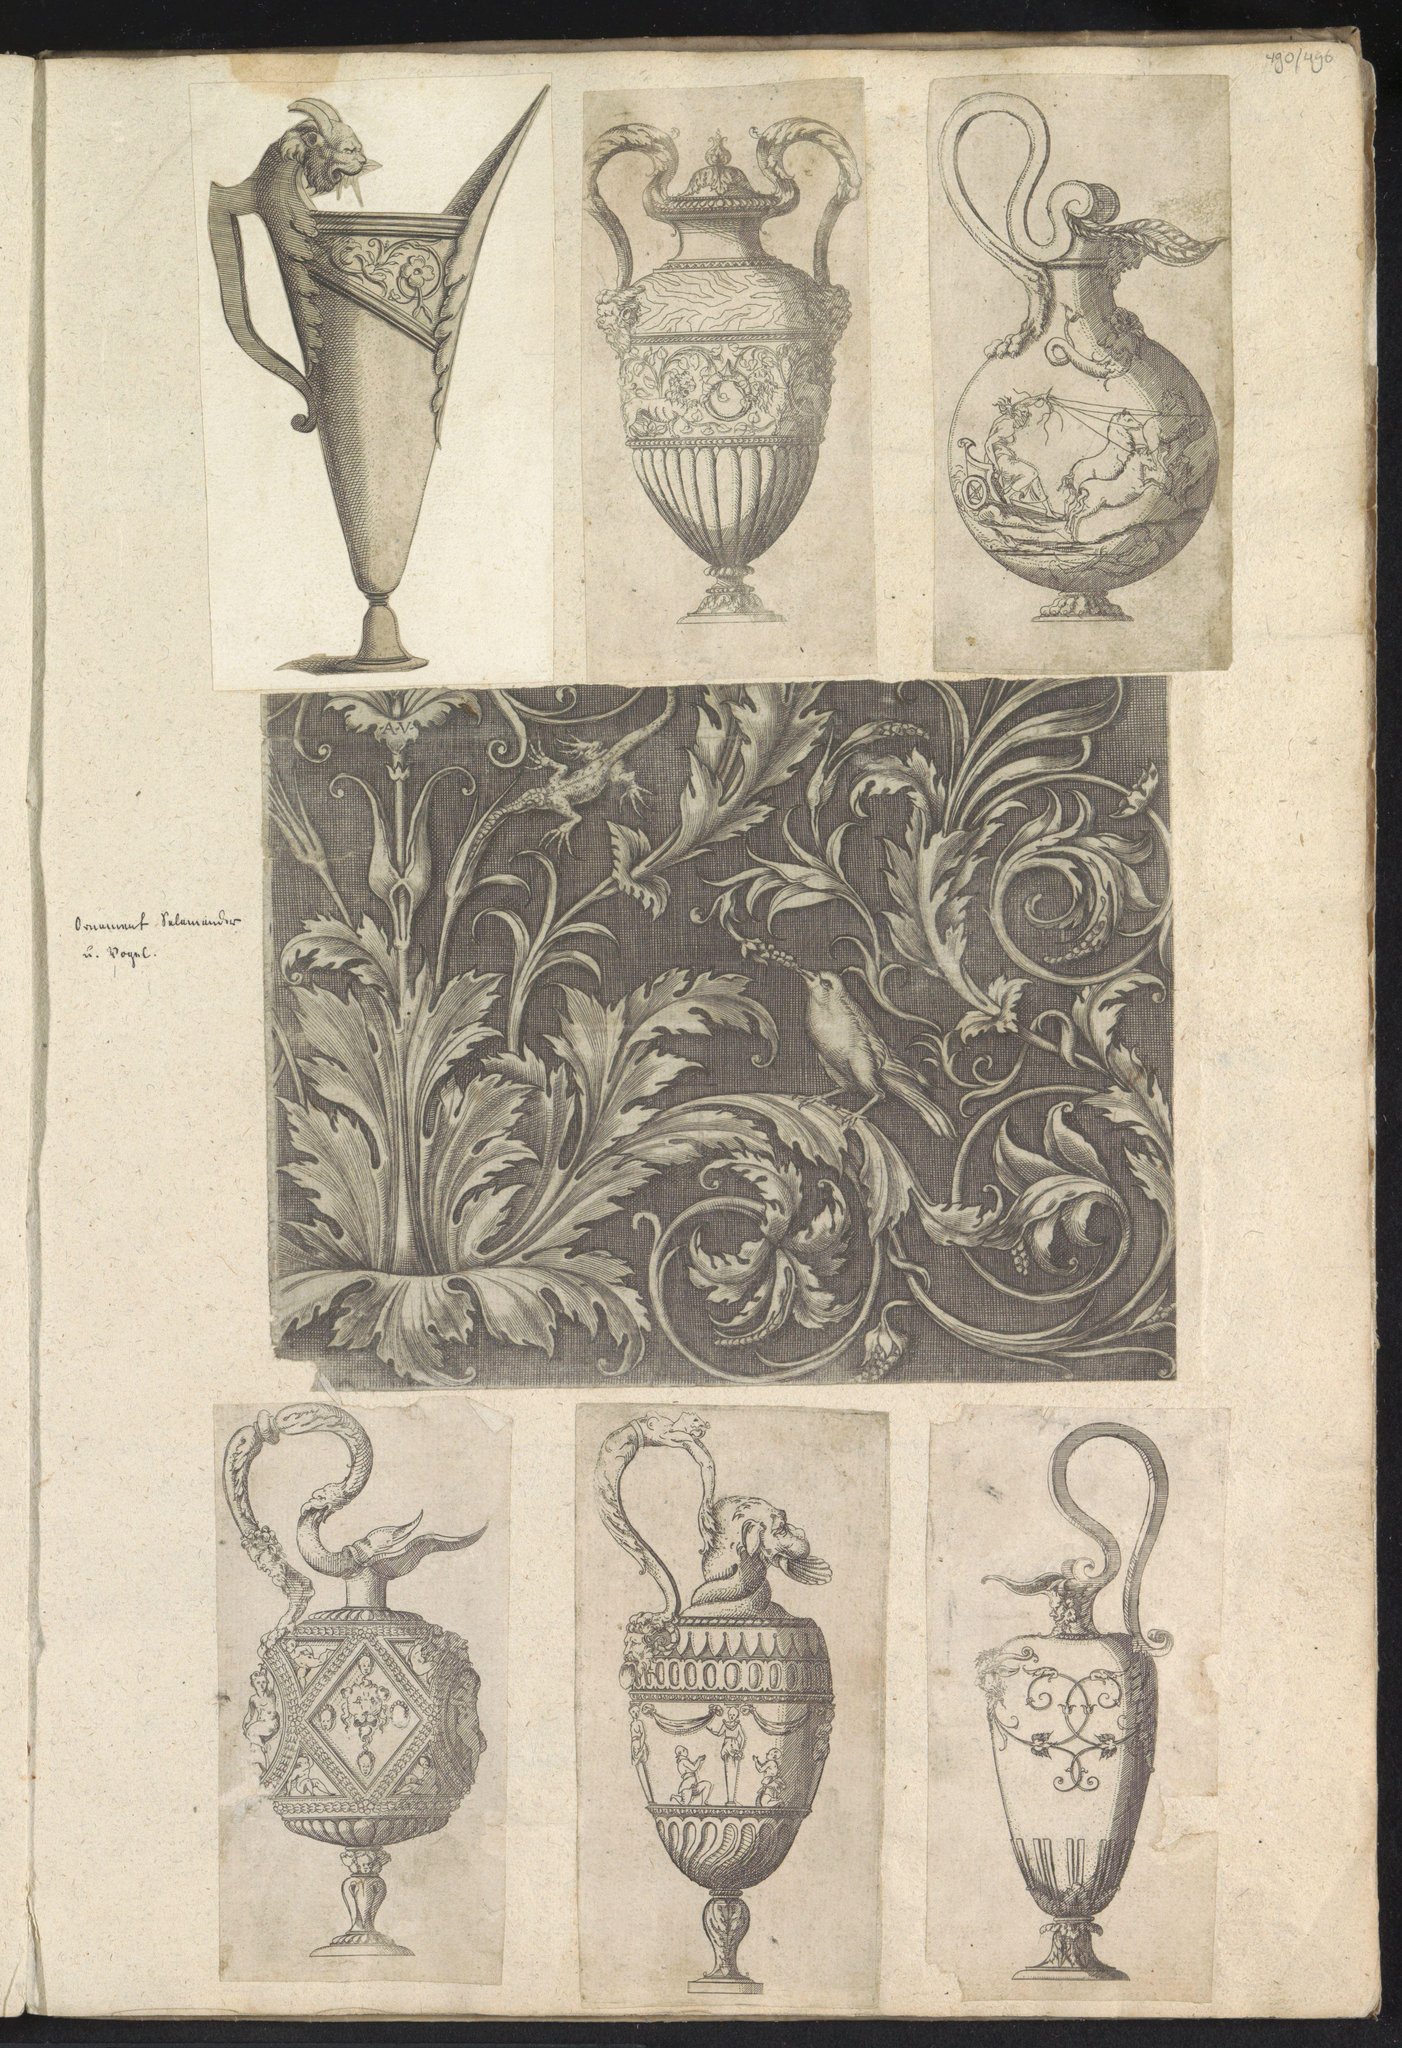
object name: print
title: Albumblad met zeven prenten met urnen, kannen en bladornament met een vogel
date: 1500-1599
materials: paper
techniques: engraving, etching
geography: italy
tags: kitchen-utensils: cauldron, ornament ~ arabesque, birds, satyr(s) (in general), urn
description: Albumblad met zeven uitgeknipte prenten: urnen, kannen en bladornament met daartussen een vogel en een hagedis die uitloopt in ornament.